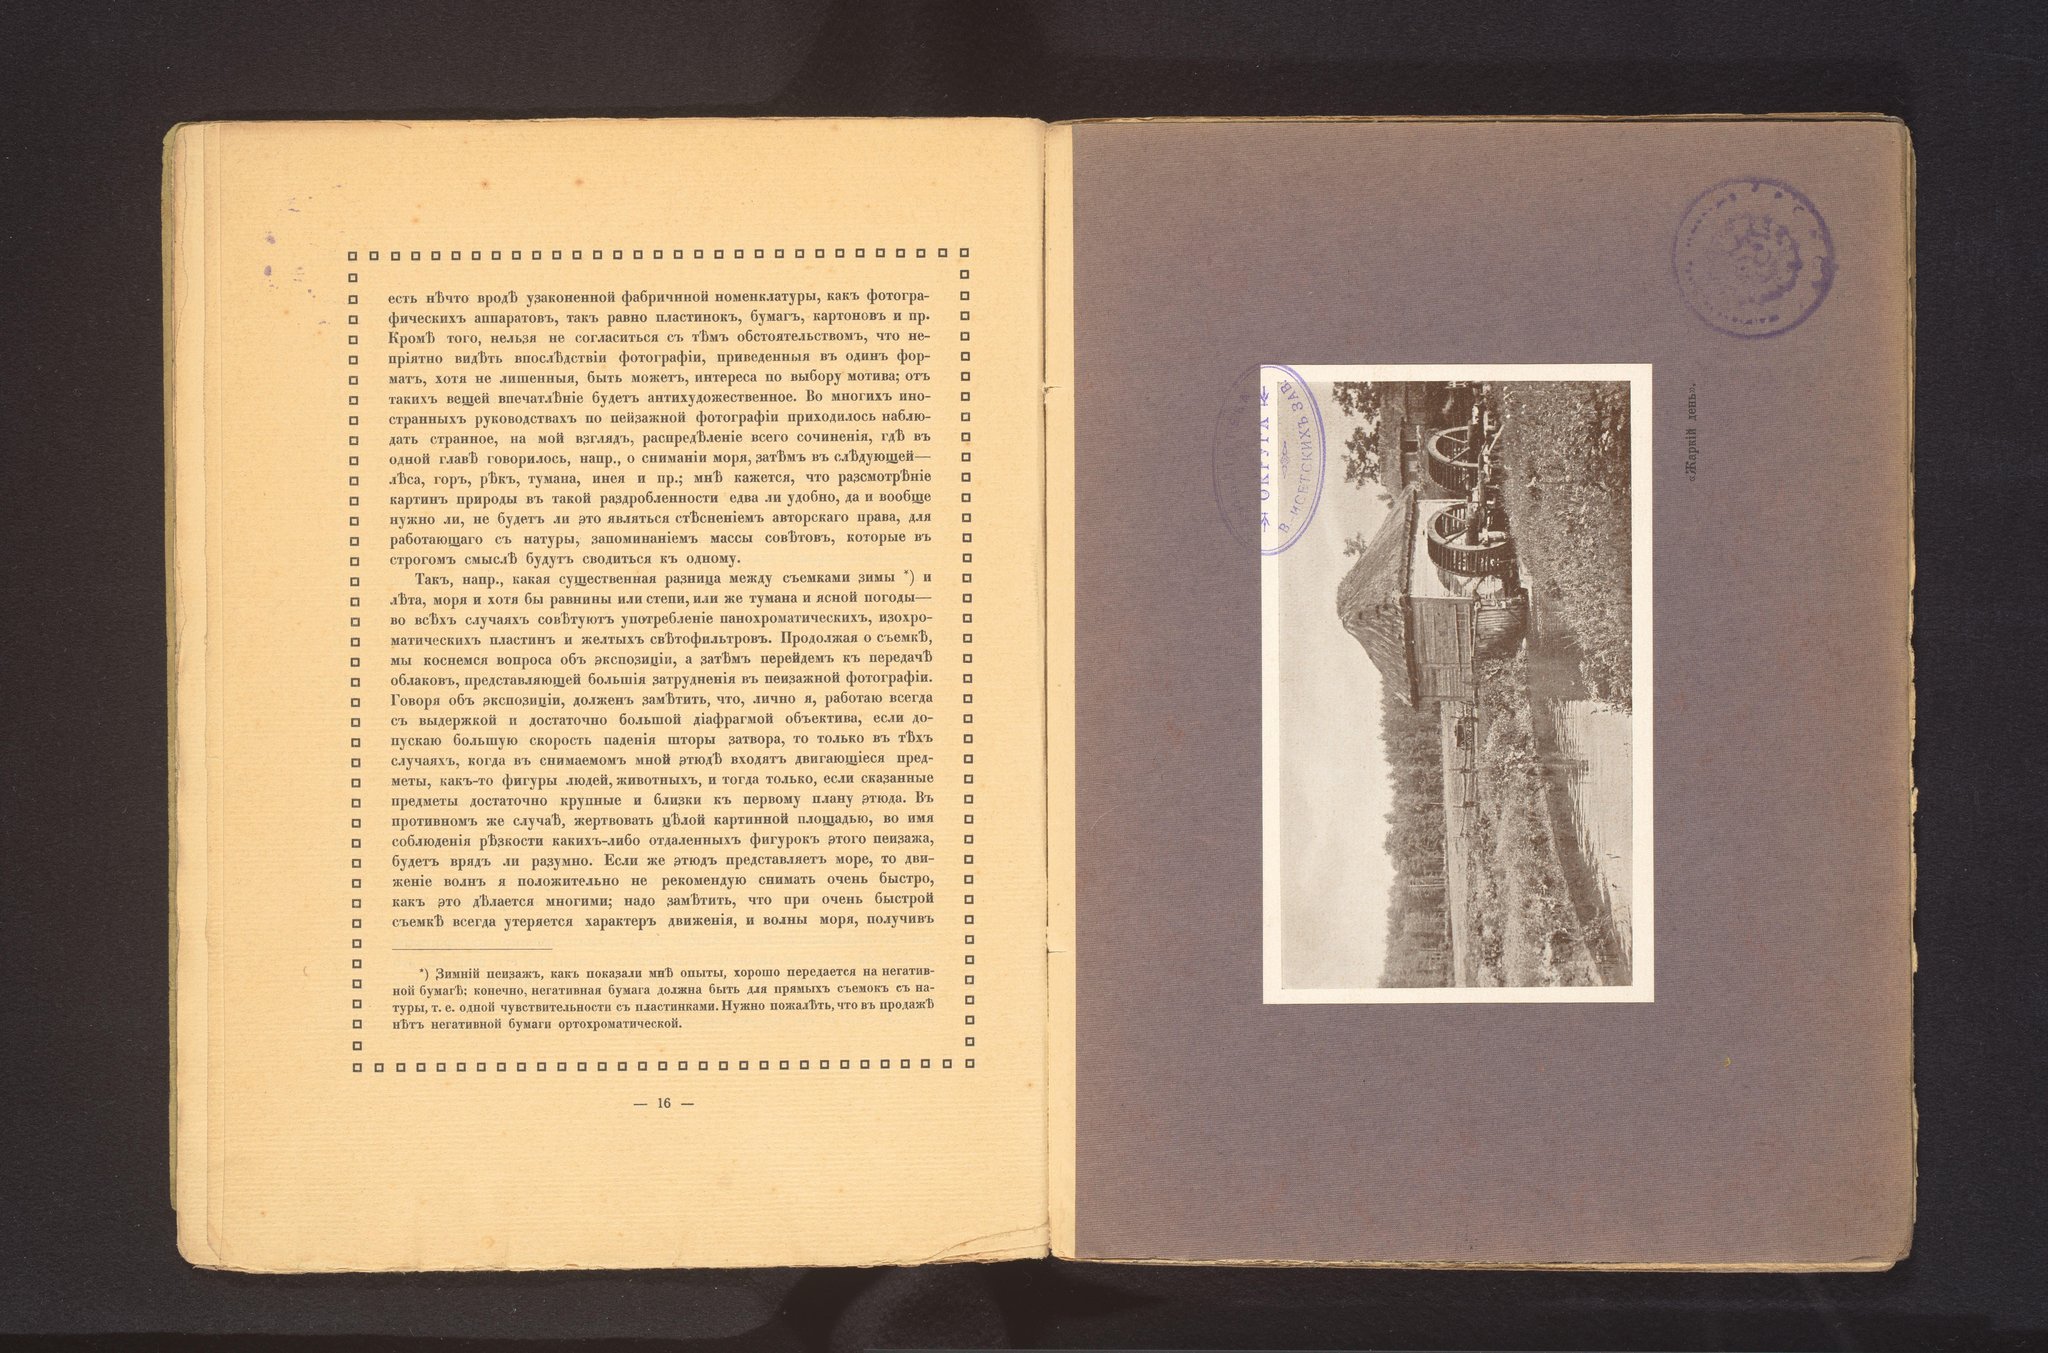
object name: photomechanical print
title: Жаркій дeнь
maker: Anonymous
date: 1897-1907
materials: paper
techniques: autotype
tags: river, watermill in landscape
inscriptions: inscription